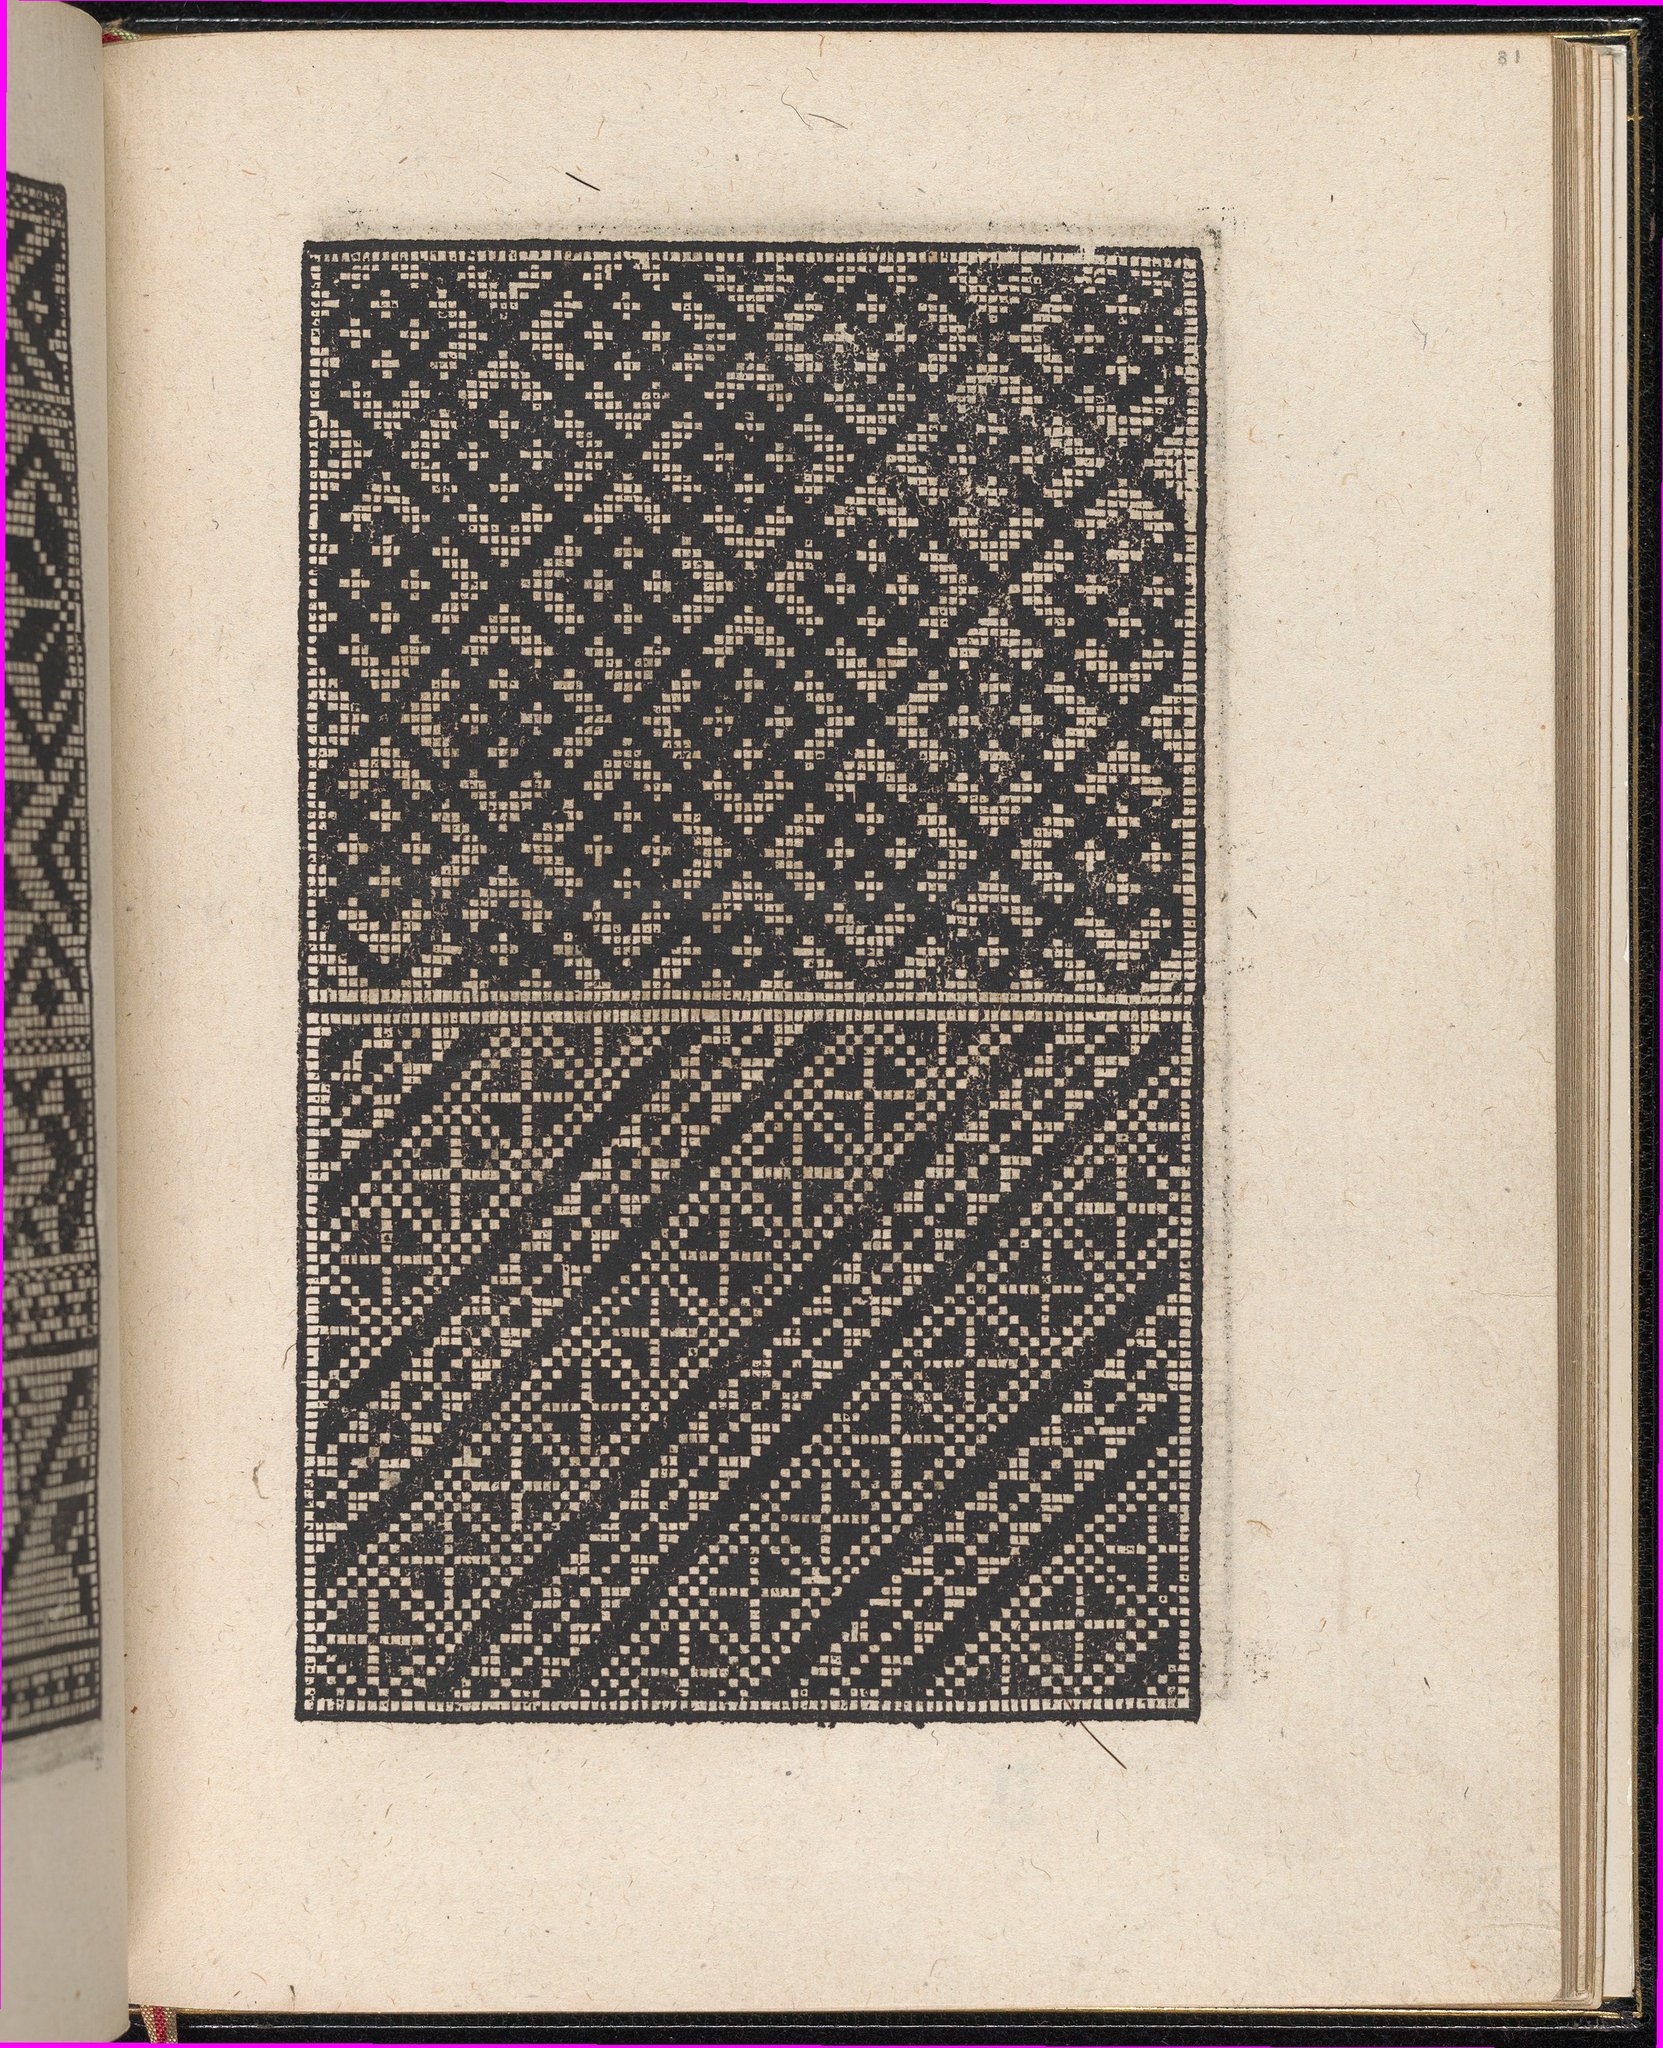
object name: book print ornament architecture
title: Page from Ein new kunstlich Modelbuch...(Page 31r)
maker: peter quentel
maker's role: publisher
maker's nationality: german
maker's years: 1500-1550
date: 1544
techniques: woodcut